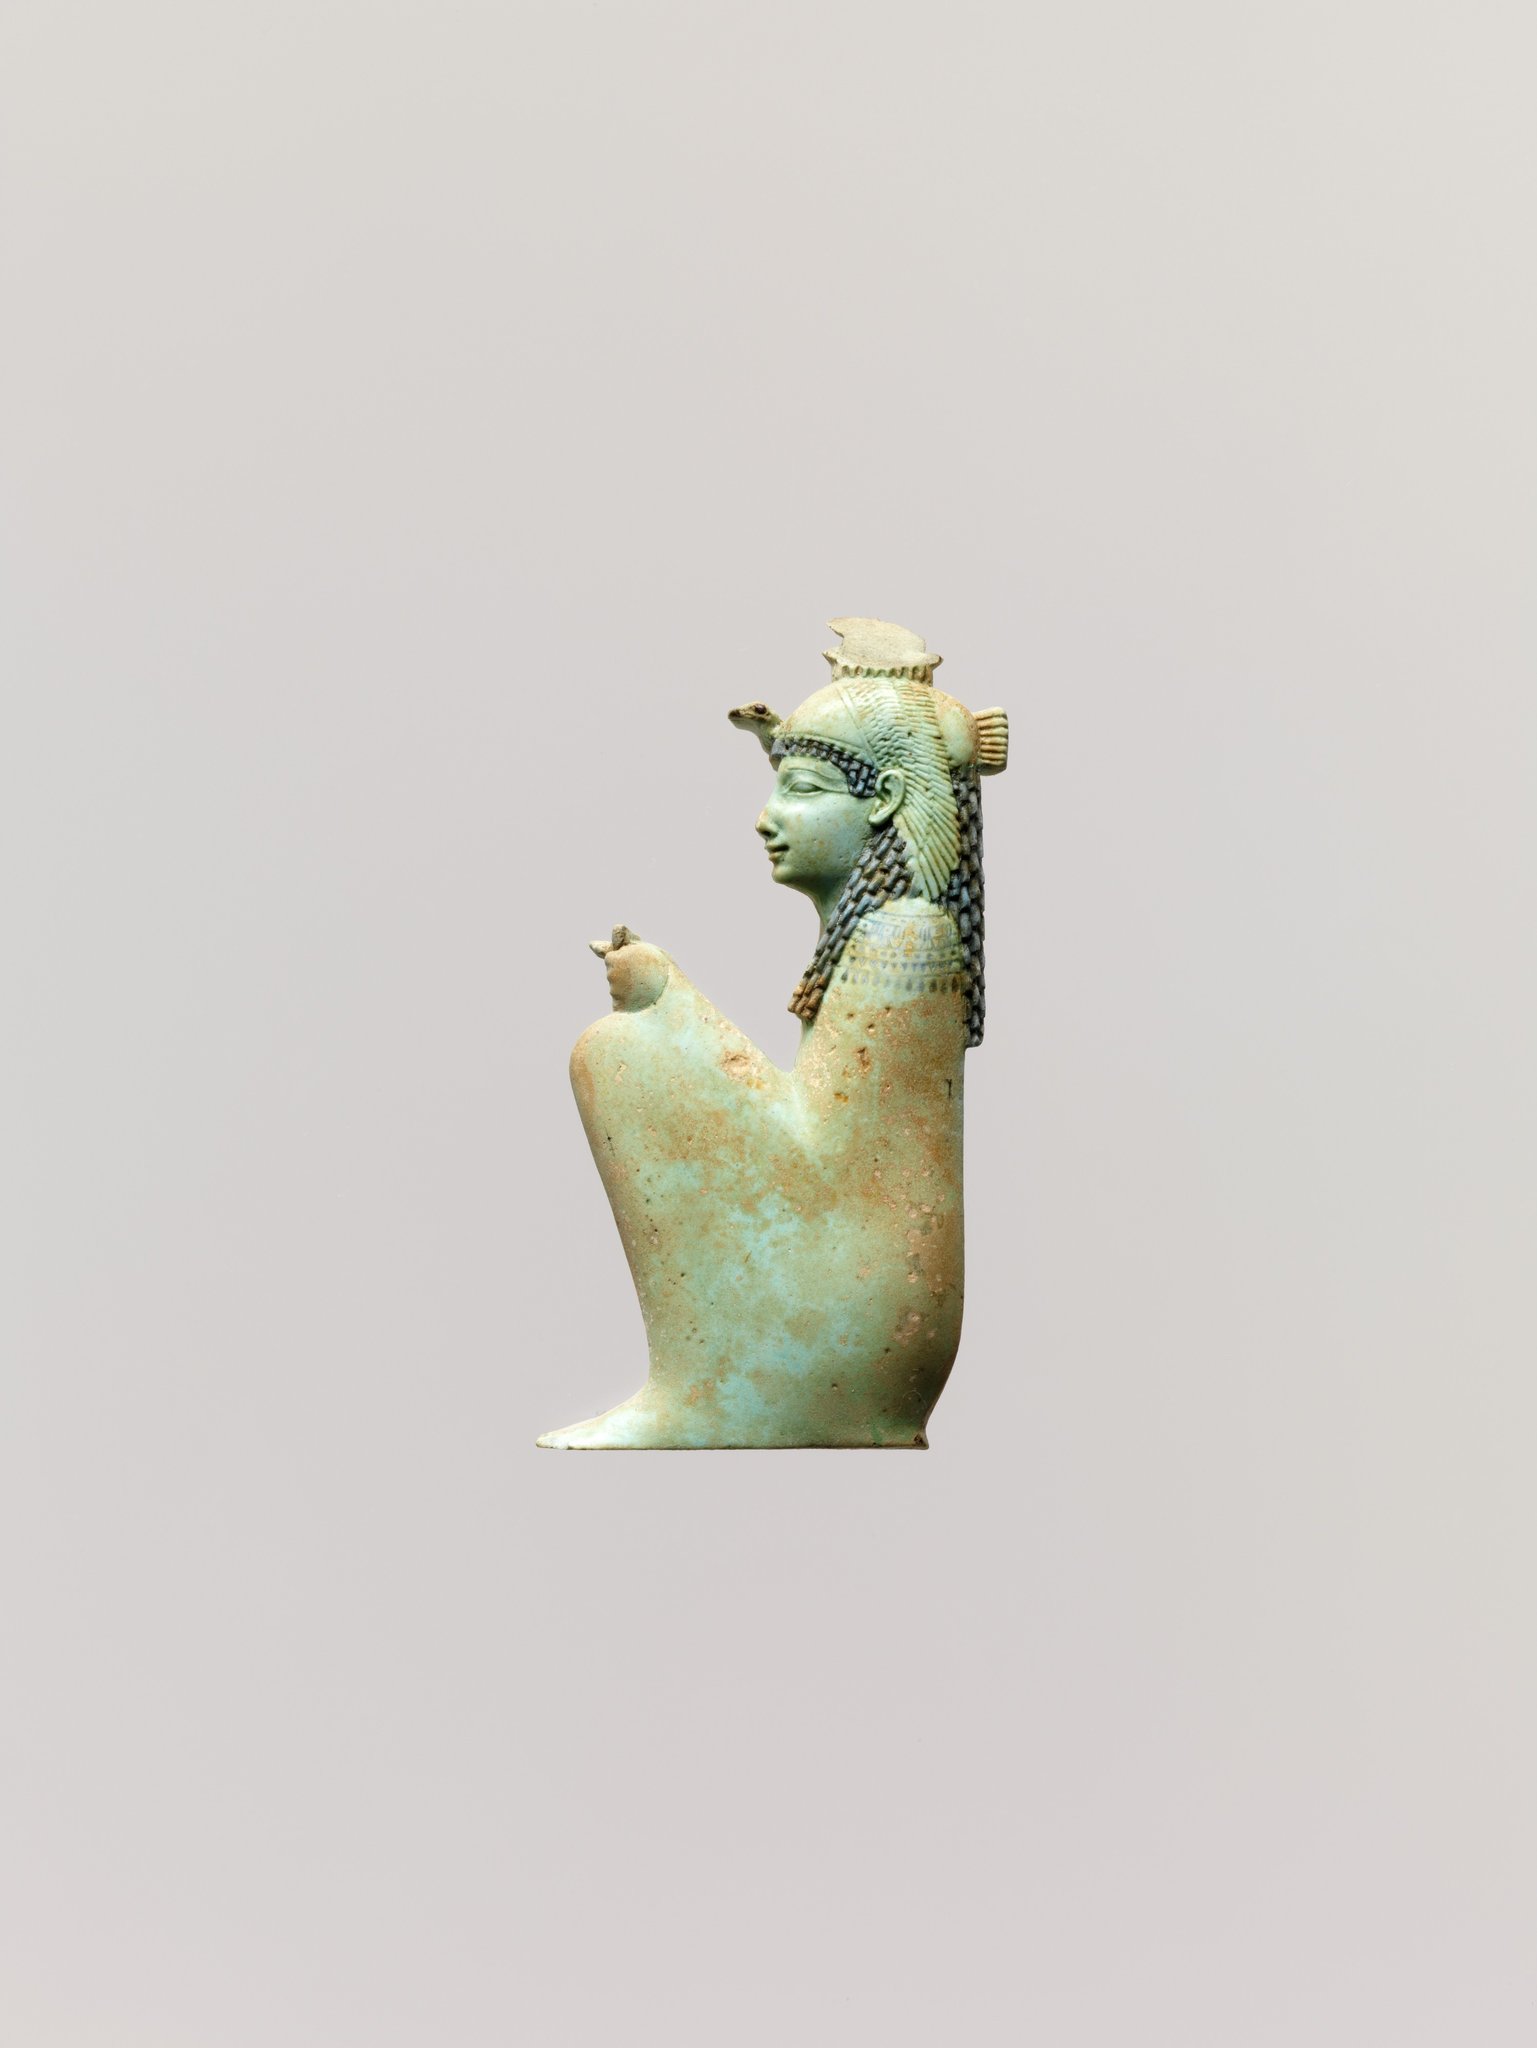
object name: inlay, goddess, facing left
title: Inlay depicting squatting goddess, probably Hathor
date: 400-301 BCE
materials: faience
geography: middle egypt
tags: hathor